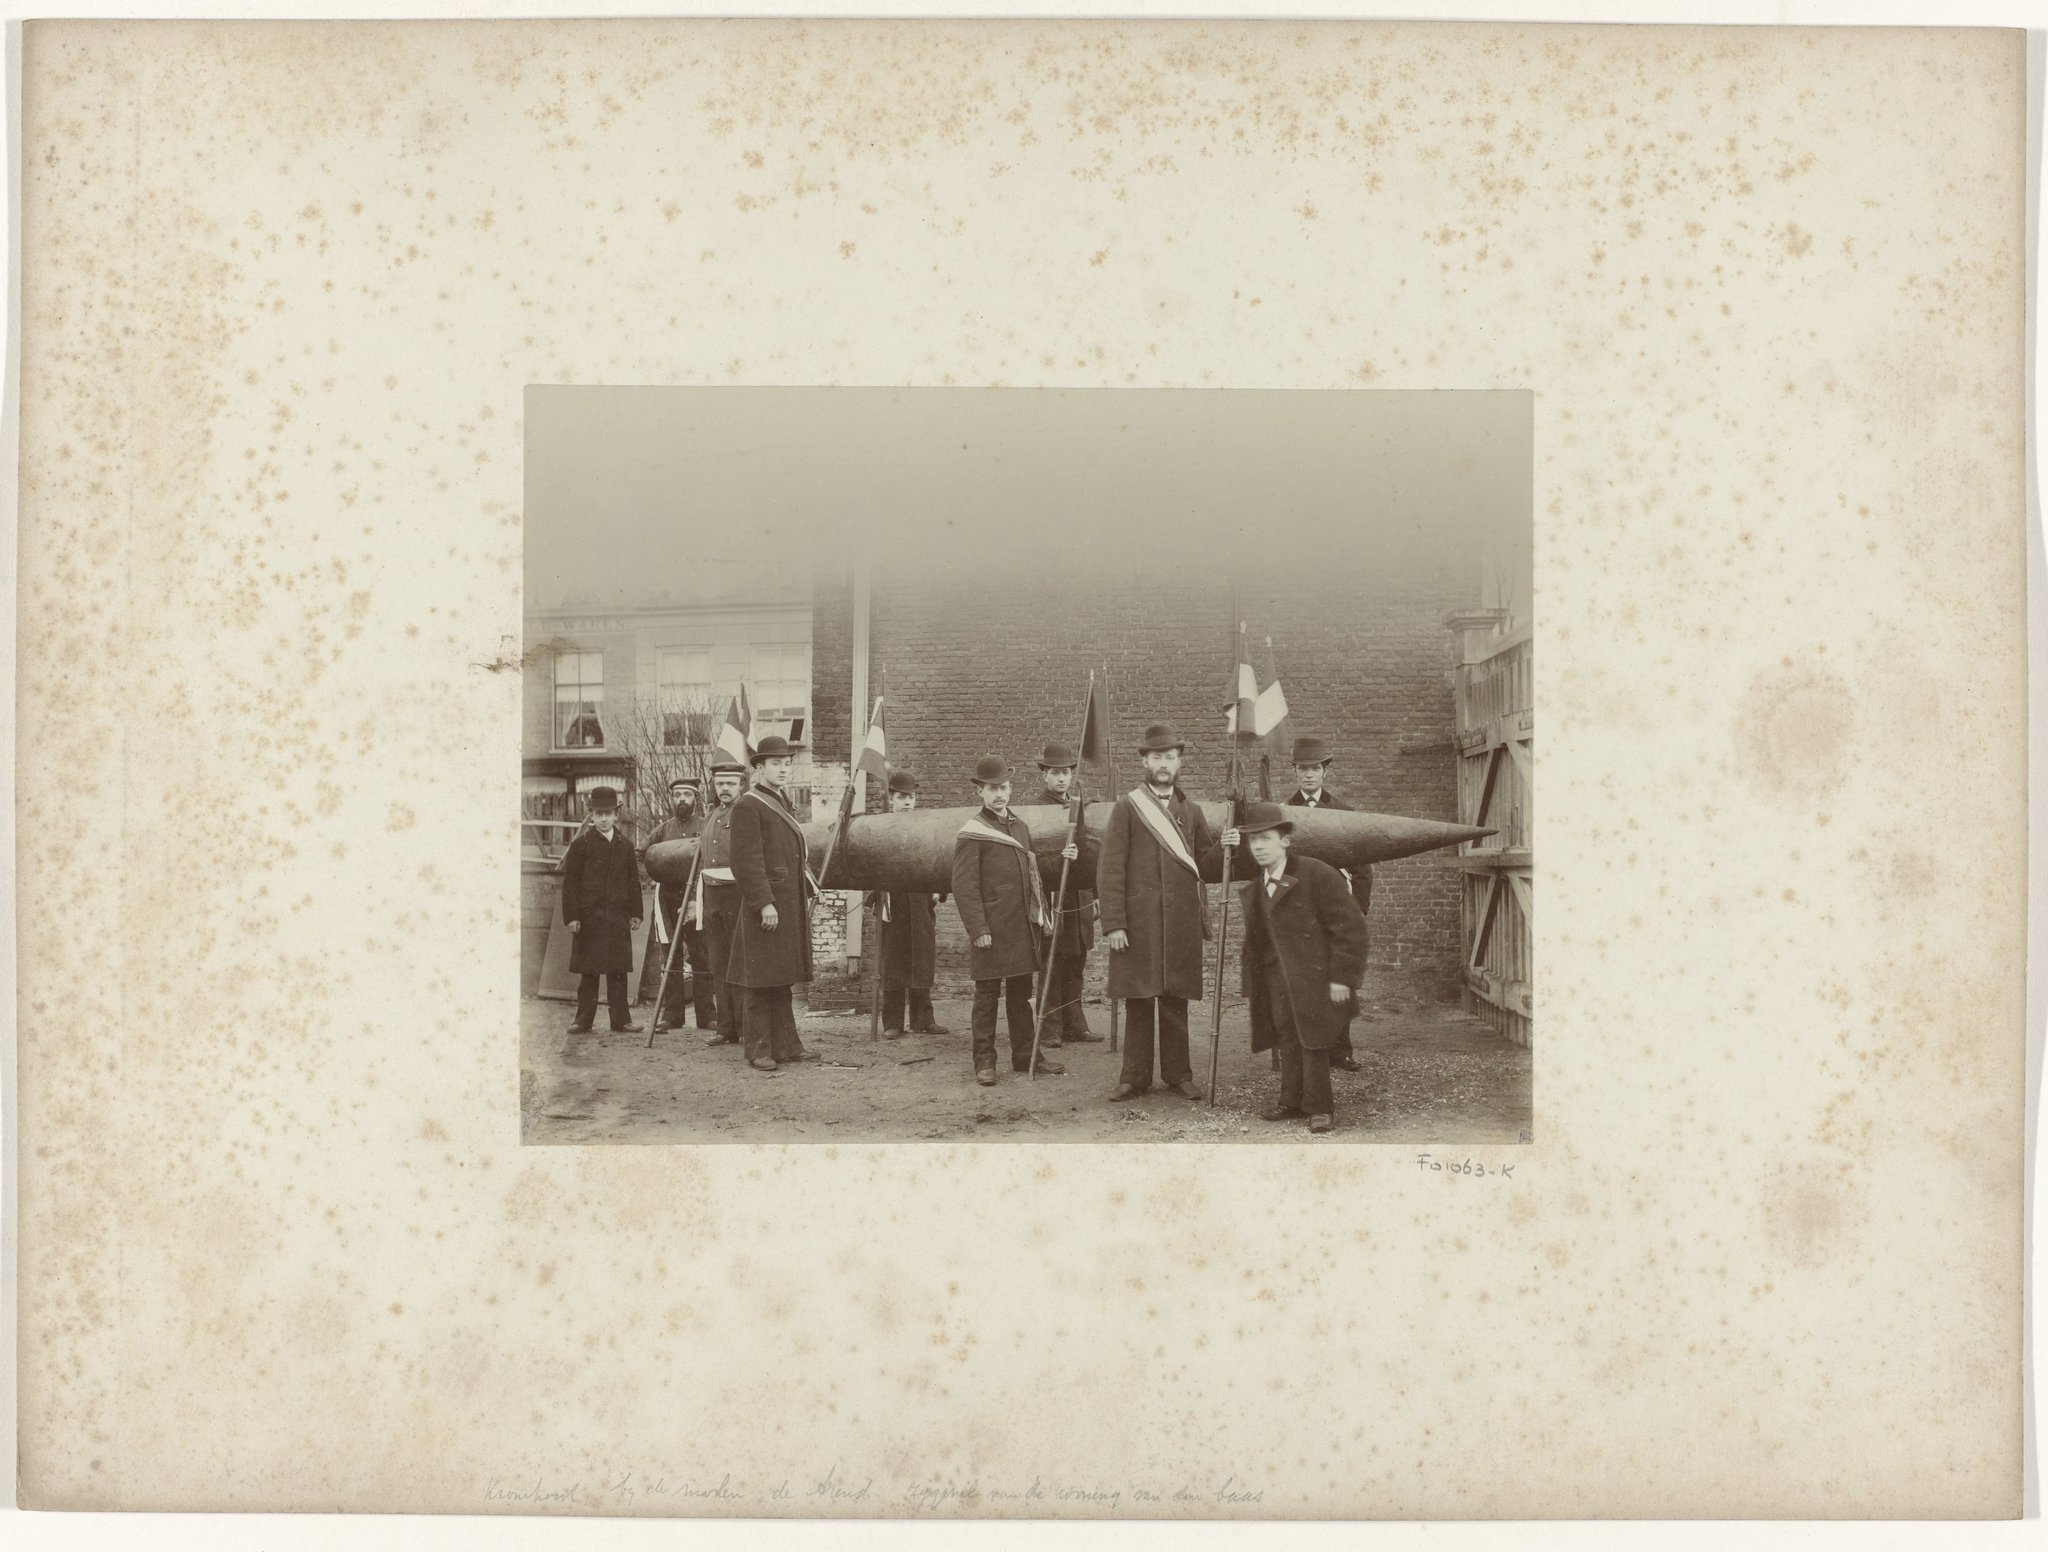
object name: photograph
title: Mannen met vlaggen bij de 6 meter lange Oranjesigaar ter gelegenheid van de onafhankelijkheidsfeesten in Dordrecht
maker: Anonymous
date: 1888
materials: cardboard, paper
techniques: albumen print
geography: dordrecht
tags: cigar, public festivities, dordrecht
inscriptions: inscription: ‘Dit is op het terrein van de houtzaagmolen/ "de Trend". De muur is van het huisje van den/ baas, het stond op den hoek van Vrieseplein en Kromhout/ op den achtergrond is het rechtsche huis dat van den fotograaf/ Karel le Grand. en de kruidenier Feitenberg? [?]’